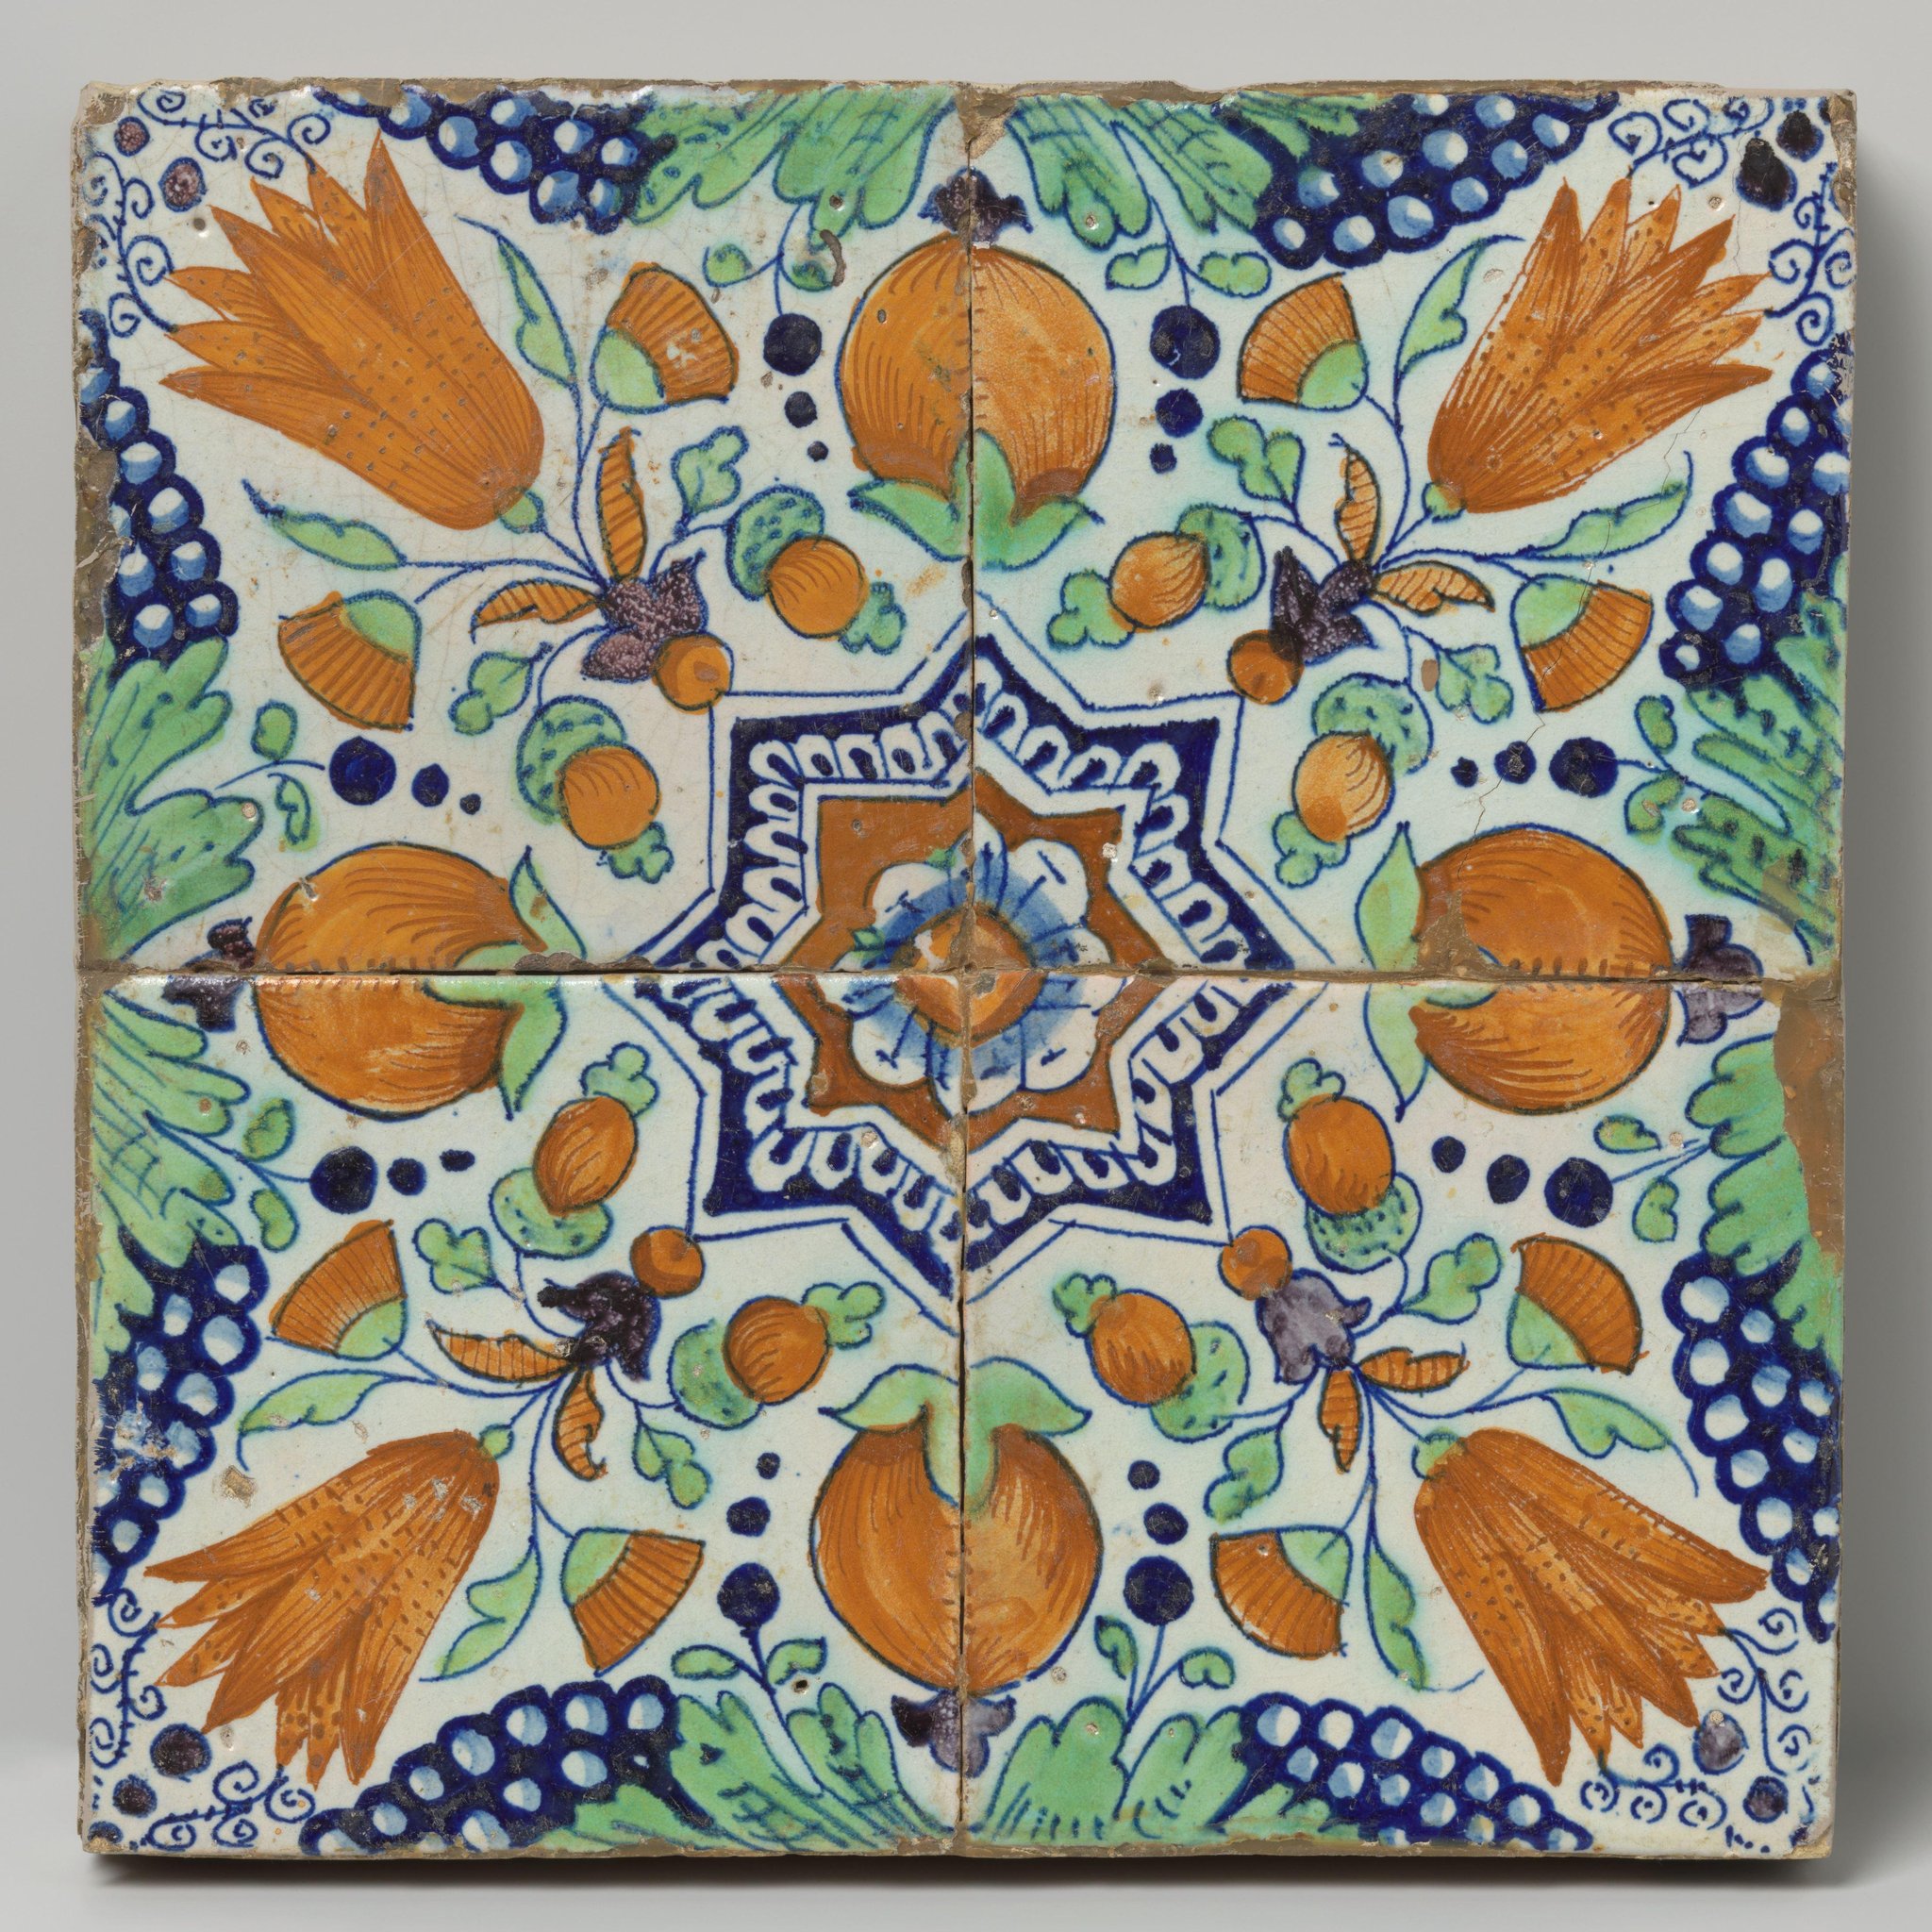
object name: tile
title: Veld van vier tegels met patroon van granaatappels, druiventrossen, tulpen en sterren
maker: Anonymous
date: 1600-1625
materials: earthenware, glaze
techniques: maiolica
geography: netherlands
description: Veld van vier tegels (2 x 2) met een veelkleurig (blauw, groen, geel, oranje en paars) patroon gevormd door vier tegels met granaatappels, druiventrossen en tulpen rond een ster.